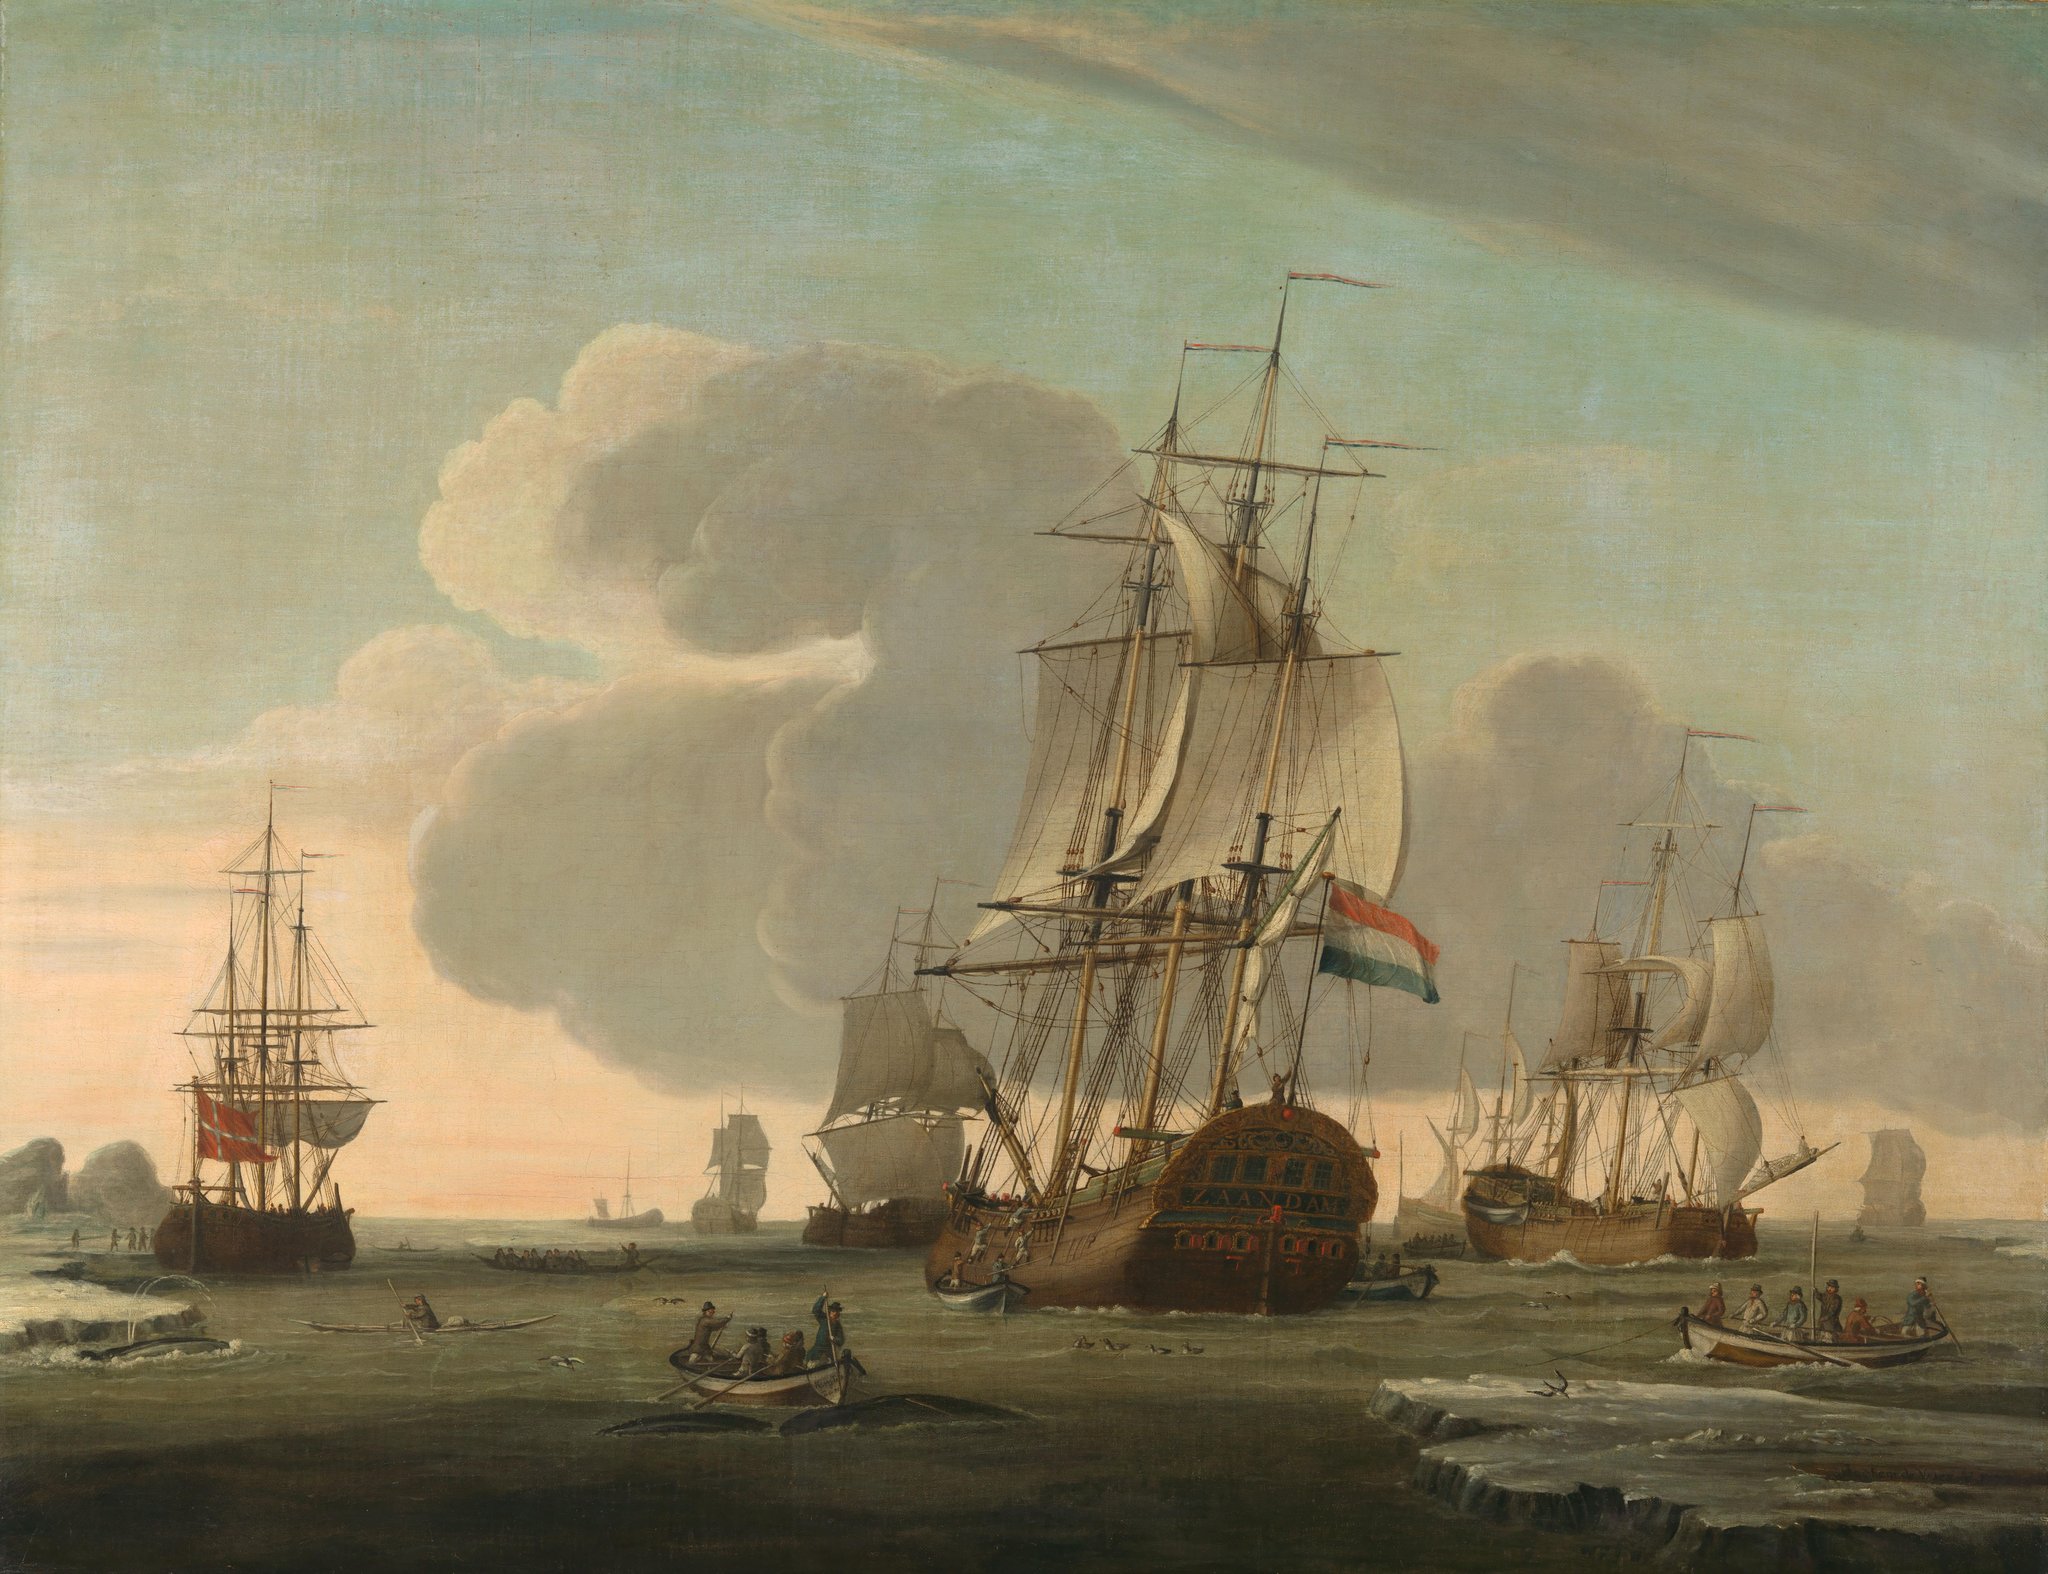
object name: painting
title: "The Groenlandvaarder ""Zaandam"" of the Shipping Company Claes Taan and Son, Zaandam, on a Whale Hunt"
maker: jochem de vries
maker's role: painter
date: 1772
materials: canvas, oil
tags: whale fishery, whaling, greenland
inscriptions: signature and date: ‘Joghem de Vries Aº 1772’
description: The Greenlandman 'Zaandam ' in the Whaling Grounds, by Joghem de Vries, 1772 .The Dutch had been hunting whales in the Arctic Ocean since the early 17th century. Oil that was extracted from the whale blubber, was used, among other things, as light fuel. Many Dutch whaling vessels sailed from Zaandam. The painter Joghem de Vries was also from Zaandam. It was there that he painted this picture of the 'Zaandam '. The ship, owned by the Zaan company of Claas Taan and Sons, was one of 38 Dutch whalers that sailed to the Davis Strait between Greenland and the North American coast in 1772. The 'Zaandam' returned with 240 barrels of blubber, taken from five whales. Altogether, the fleet killed 240 whales that year. De Vries painted other ships too. On the left is a vessel carrying the Danish flag. Two Eskimos are rowing in their kayak. And in the foreground, the men of the 'Zaandam ' have just harpooned a whale.